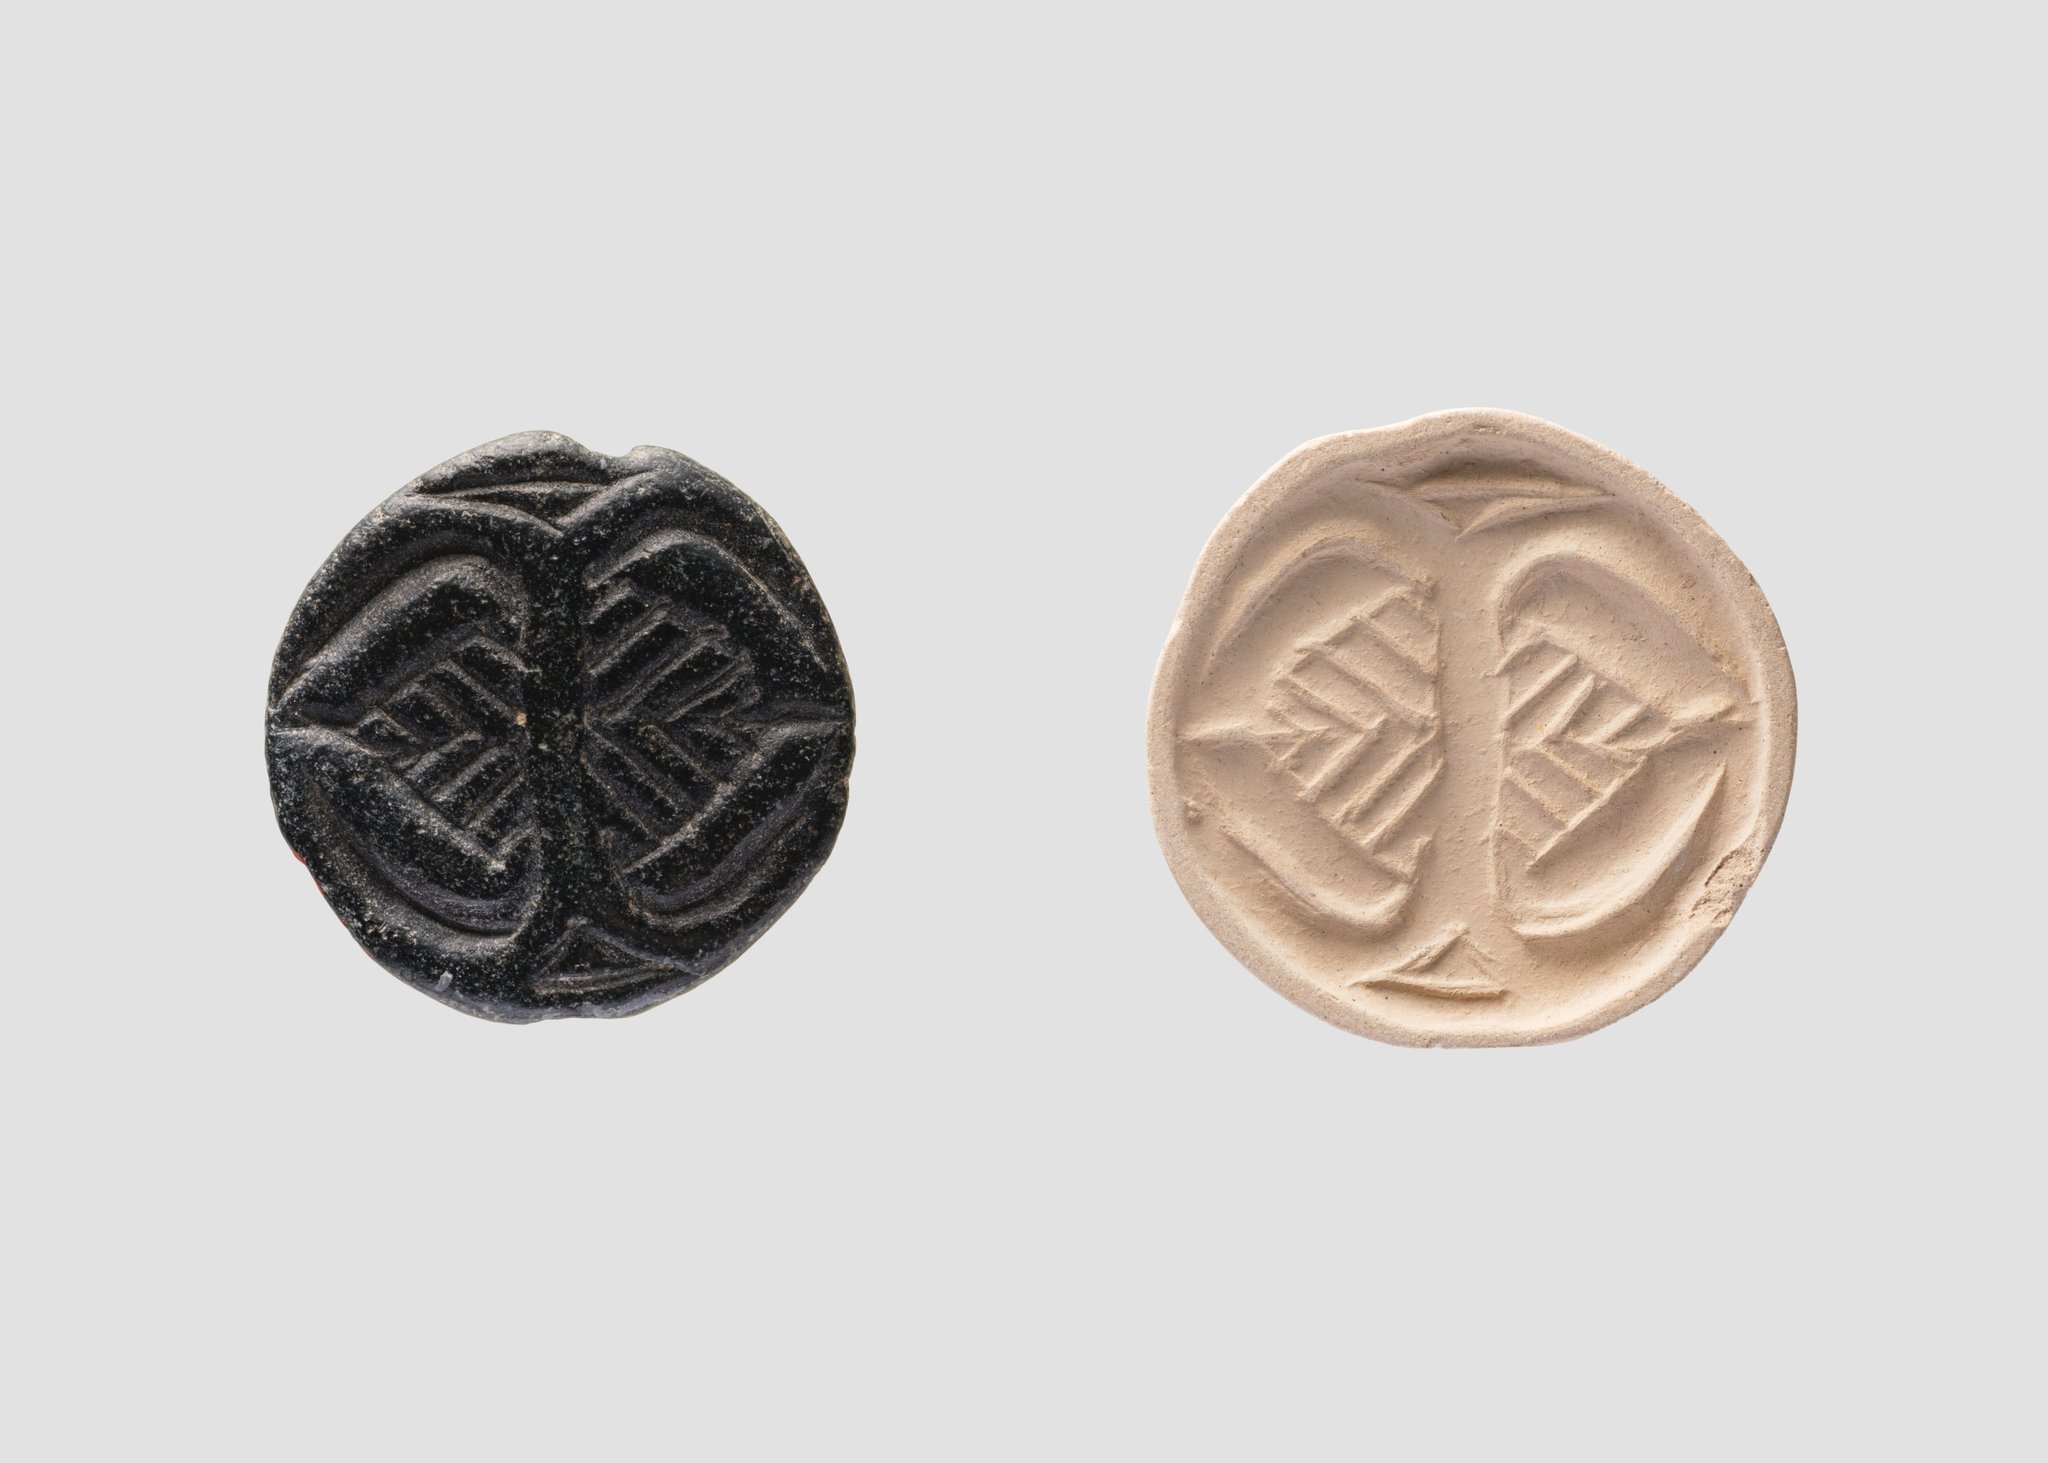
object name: stamp seal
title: Carinated lentoid seal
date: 5000-3001 BCE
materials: mineral, stone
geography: eastern anatolia